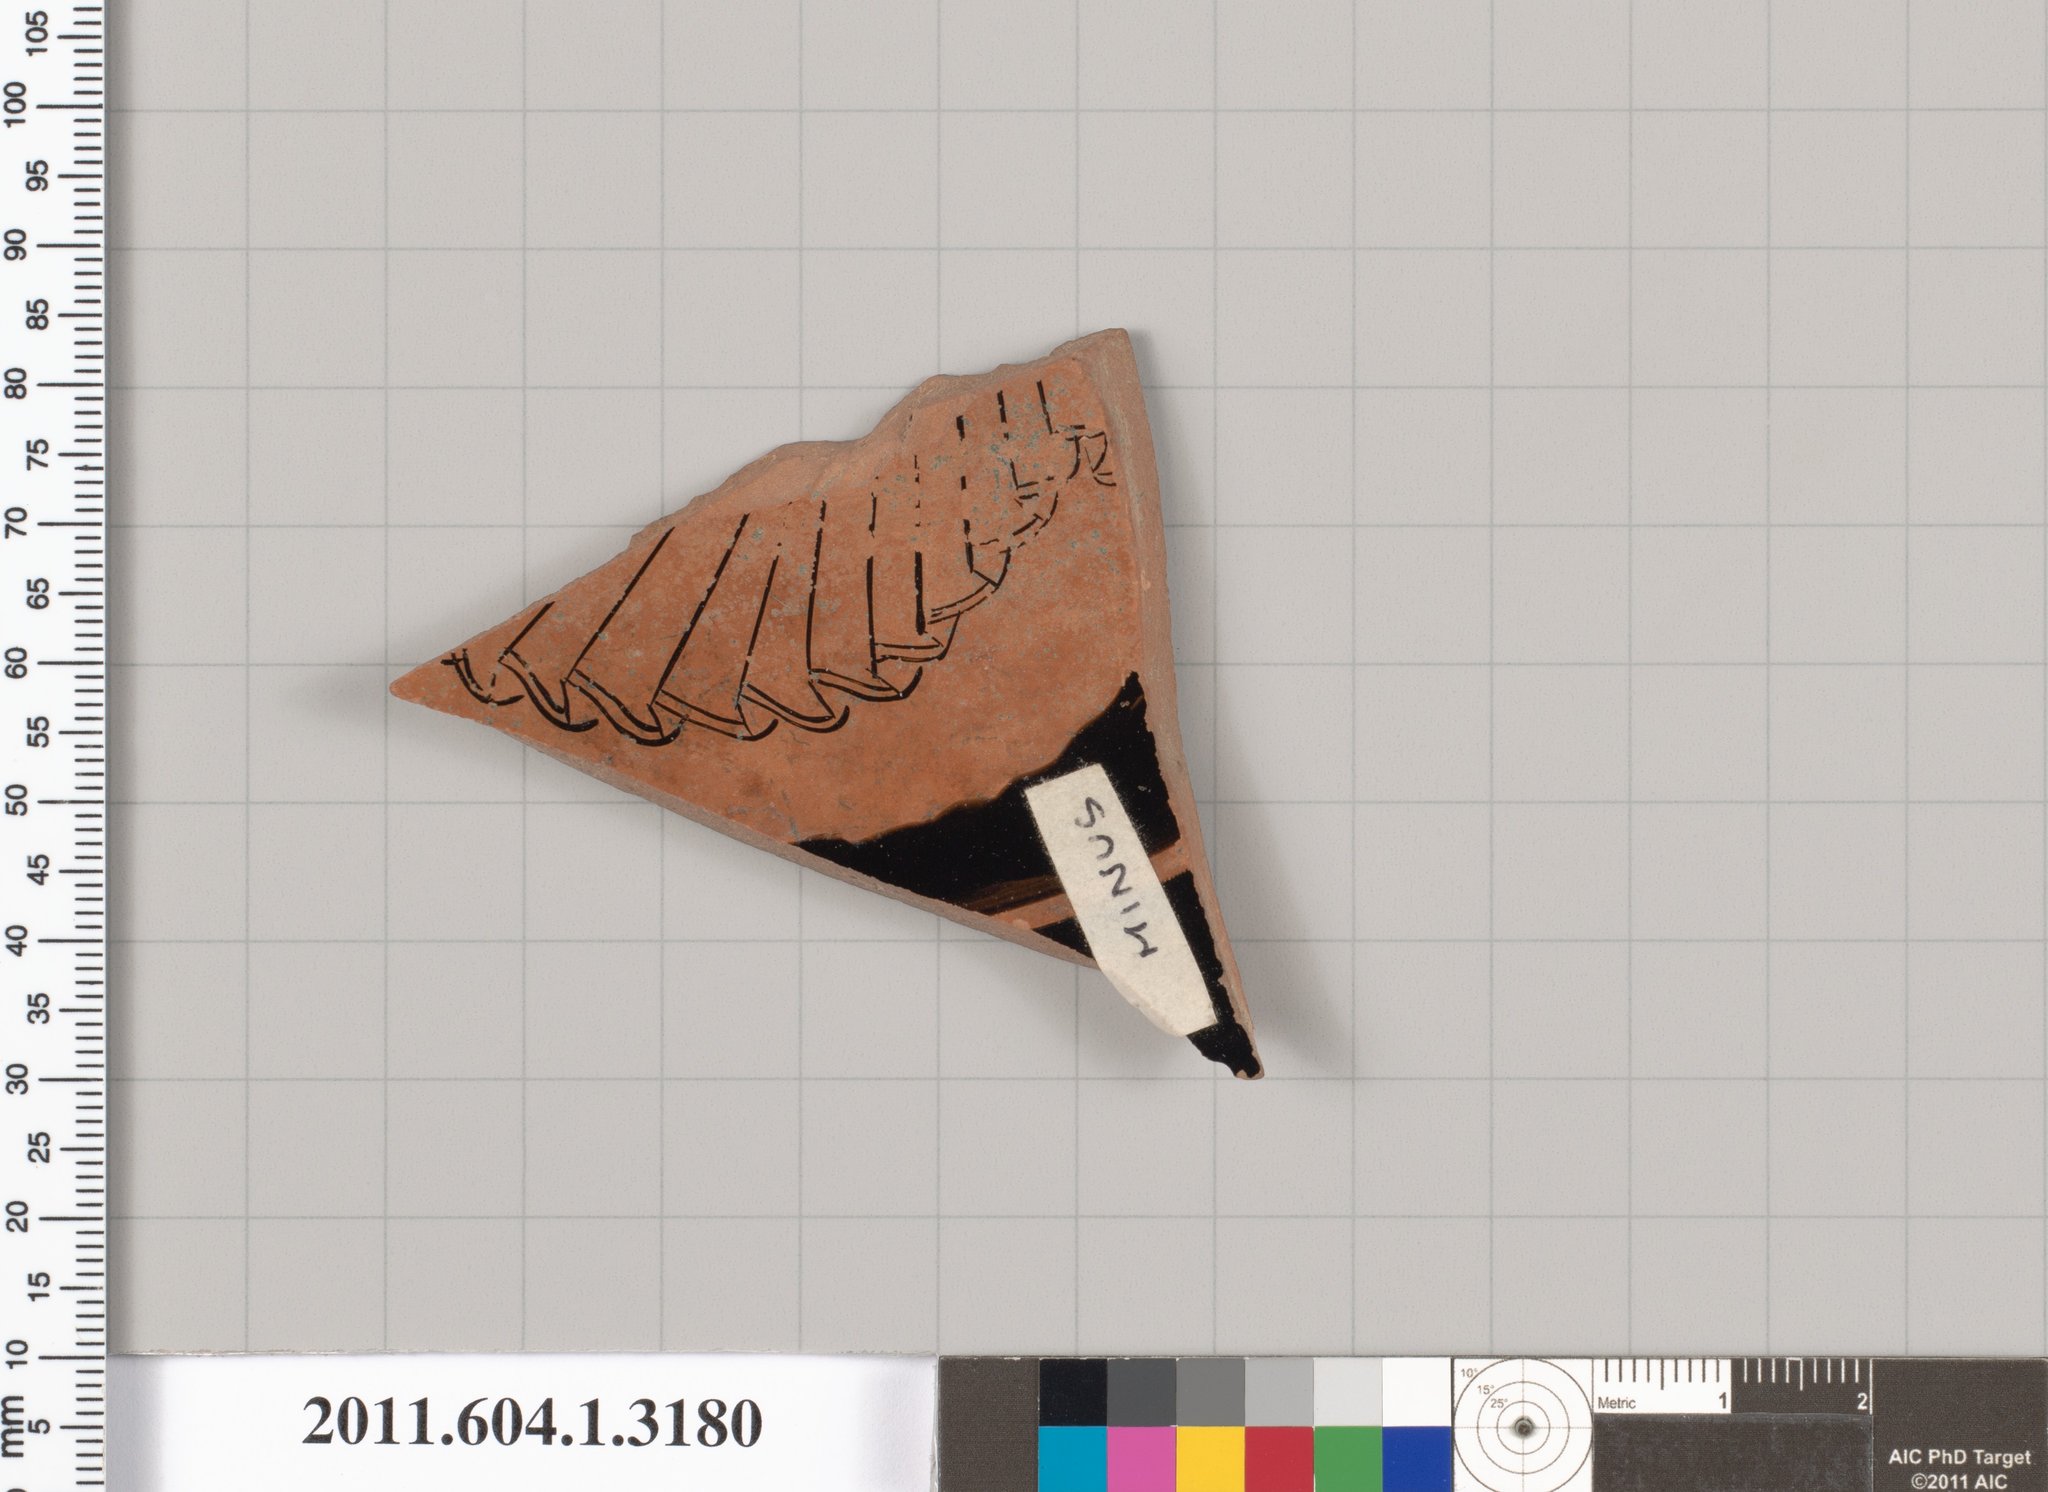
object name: kylix fragment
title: Terracotta fragment of a kylix (drinking cup)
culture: greek, attic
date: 500-480 BCE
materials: terracotta